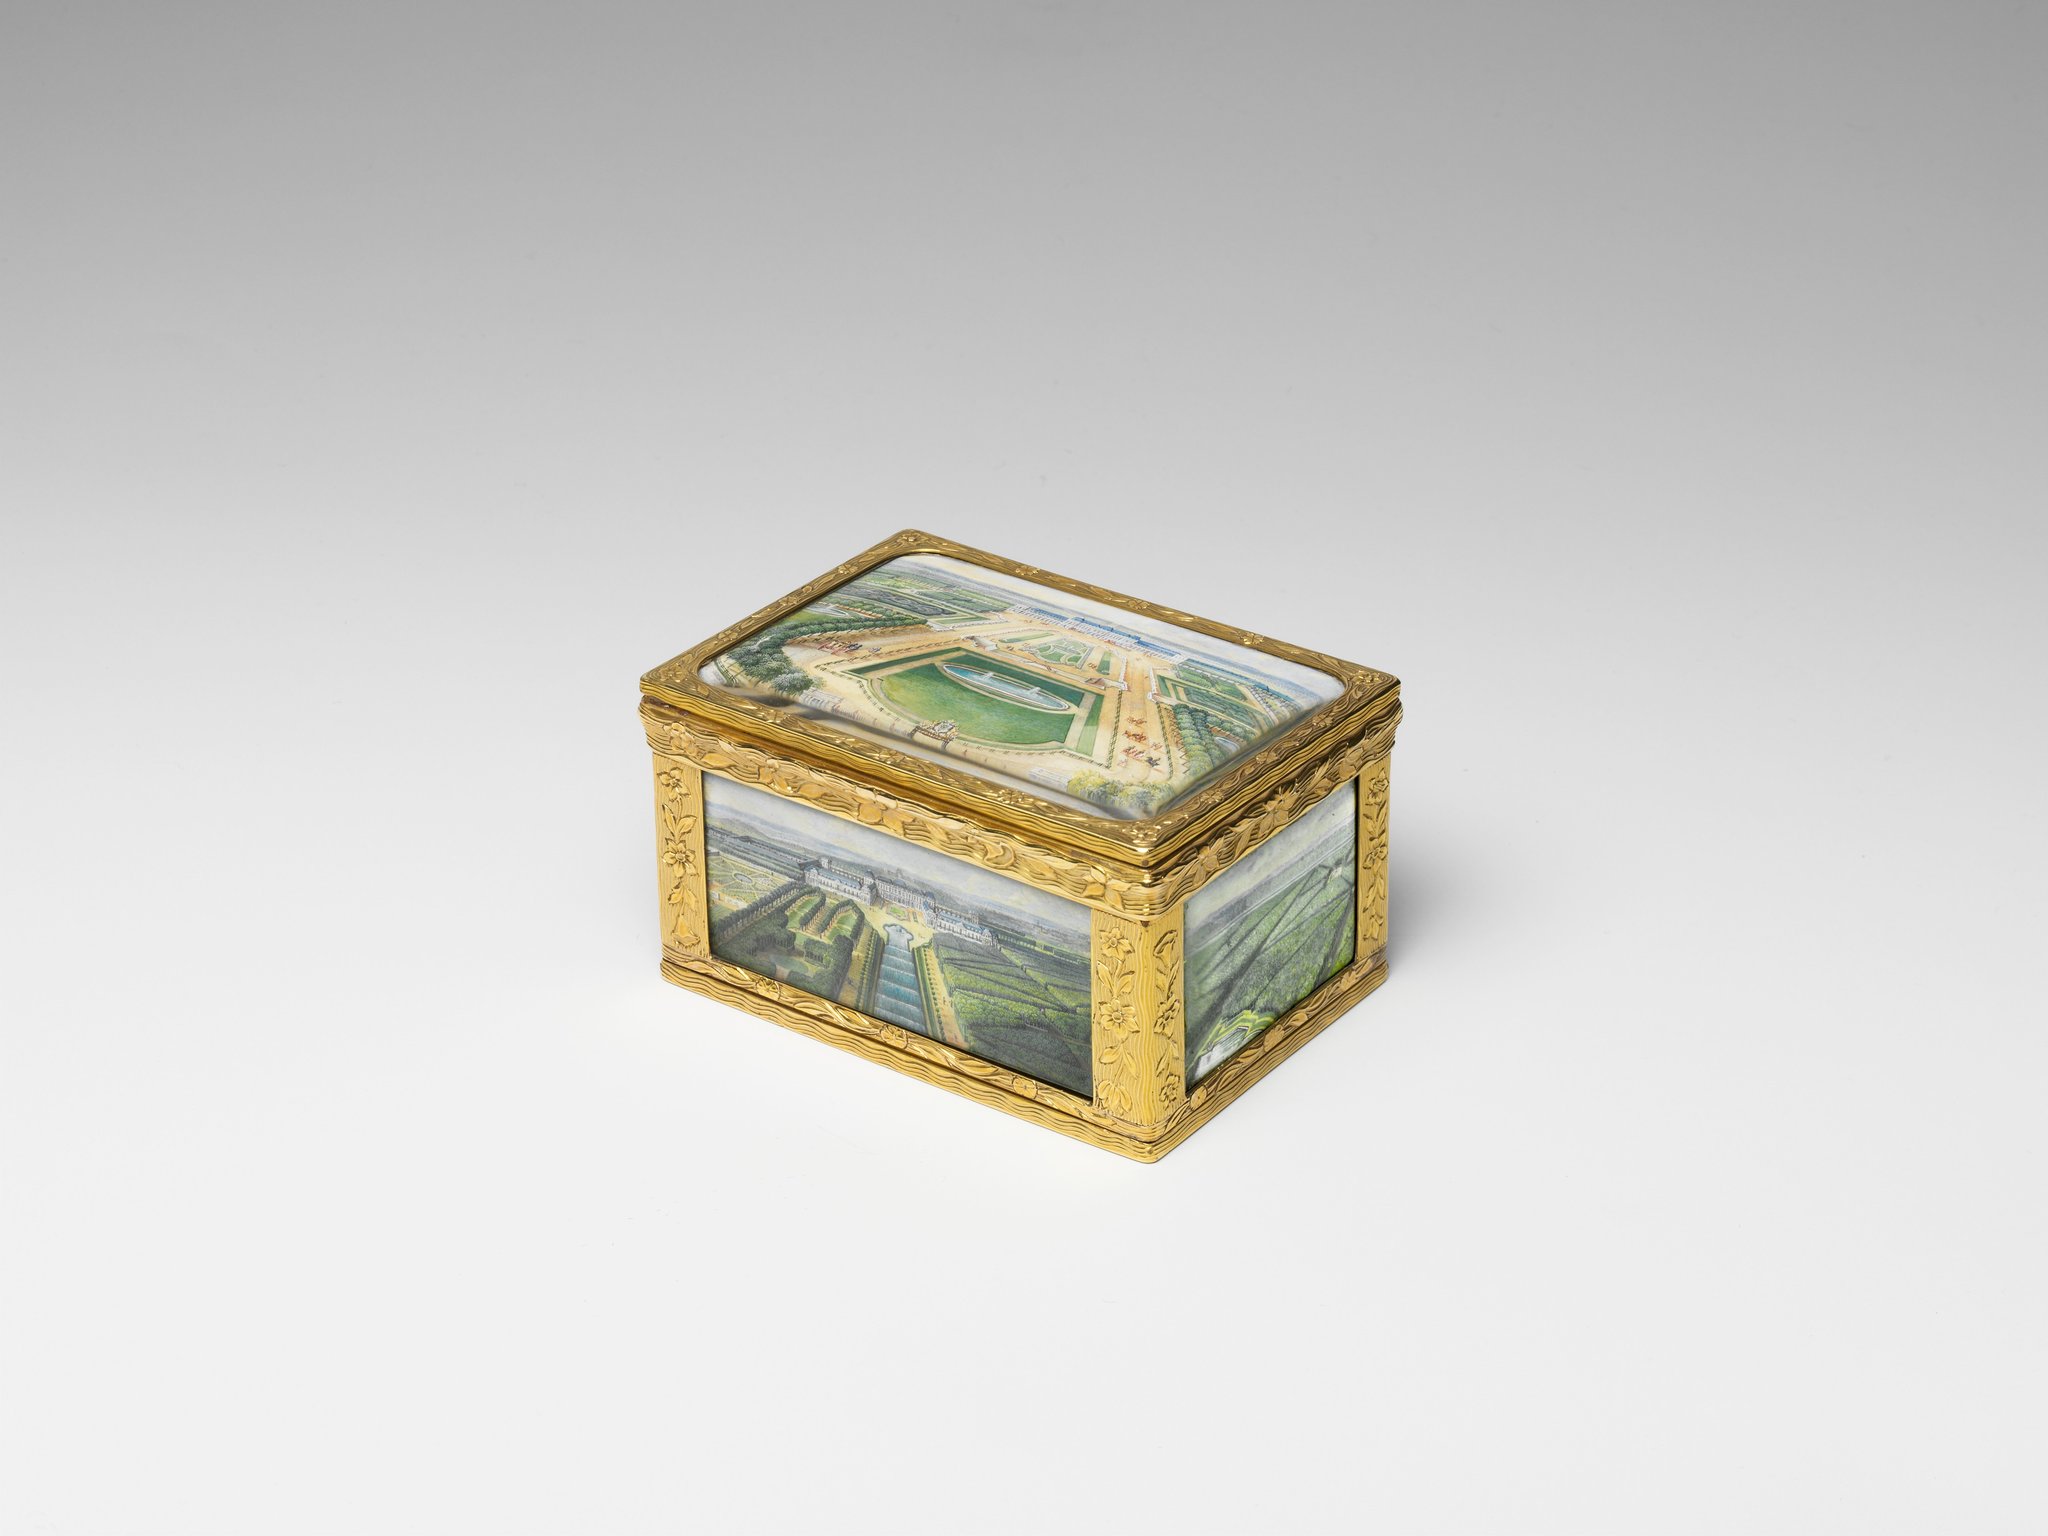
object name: snuffbox, painting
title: Snuffbox with views at the château of Chanteloup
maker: pierre-françois delafons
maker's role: maker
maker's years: 1687-1787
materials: glass, gold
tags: gardens